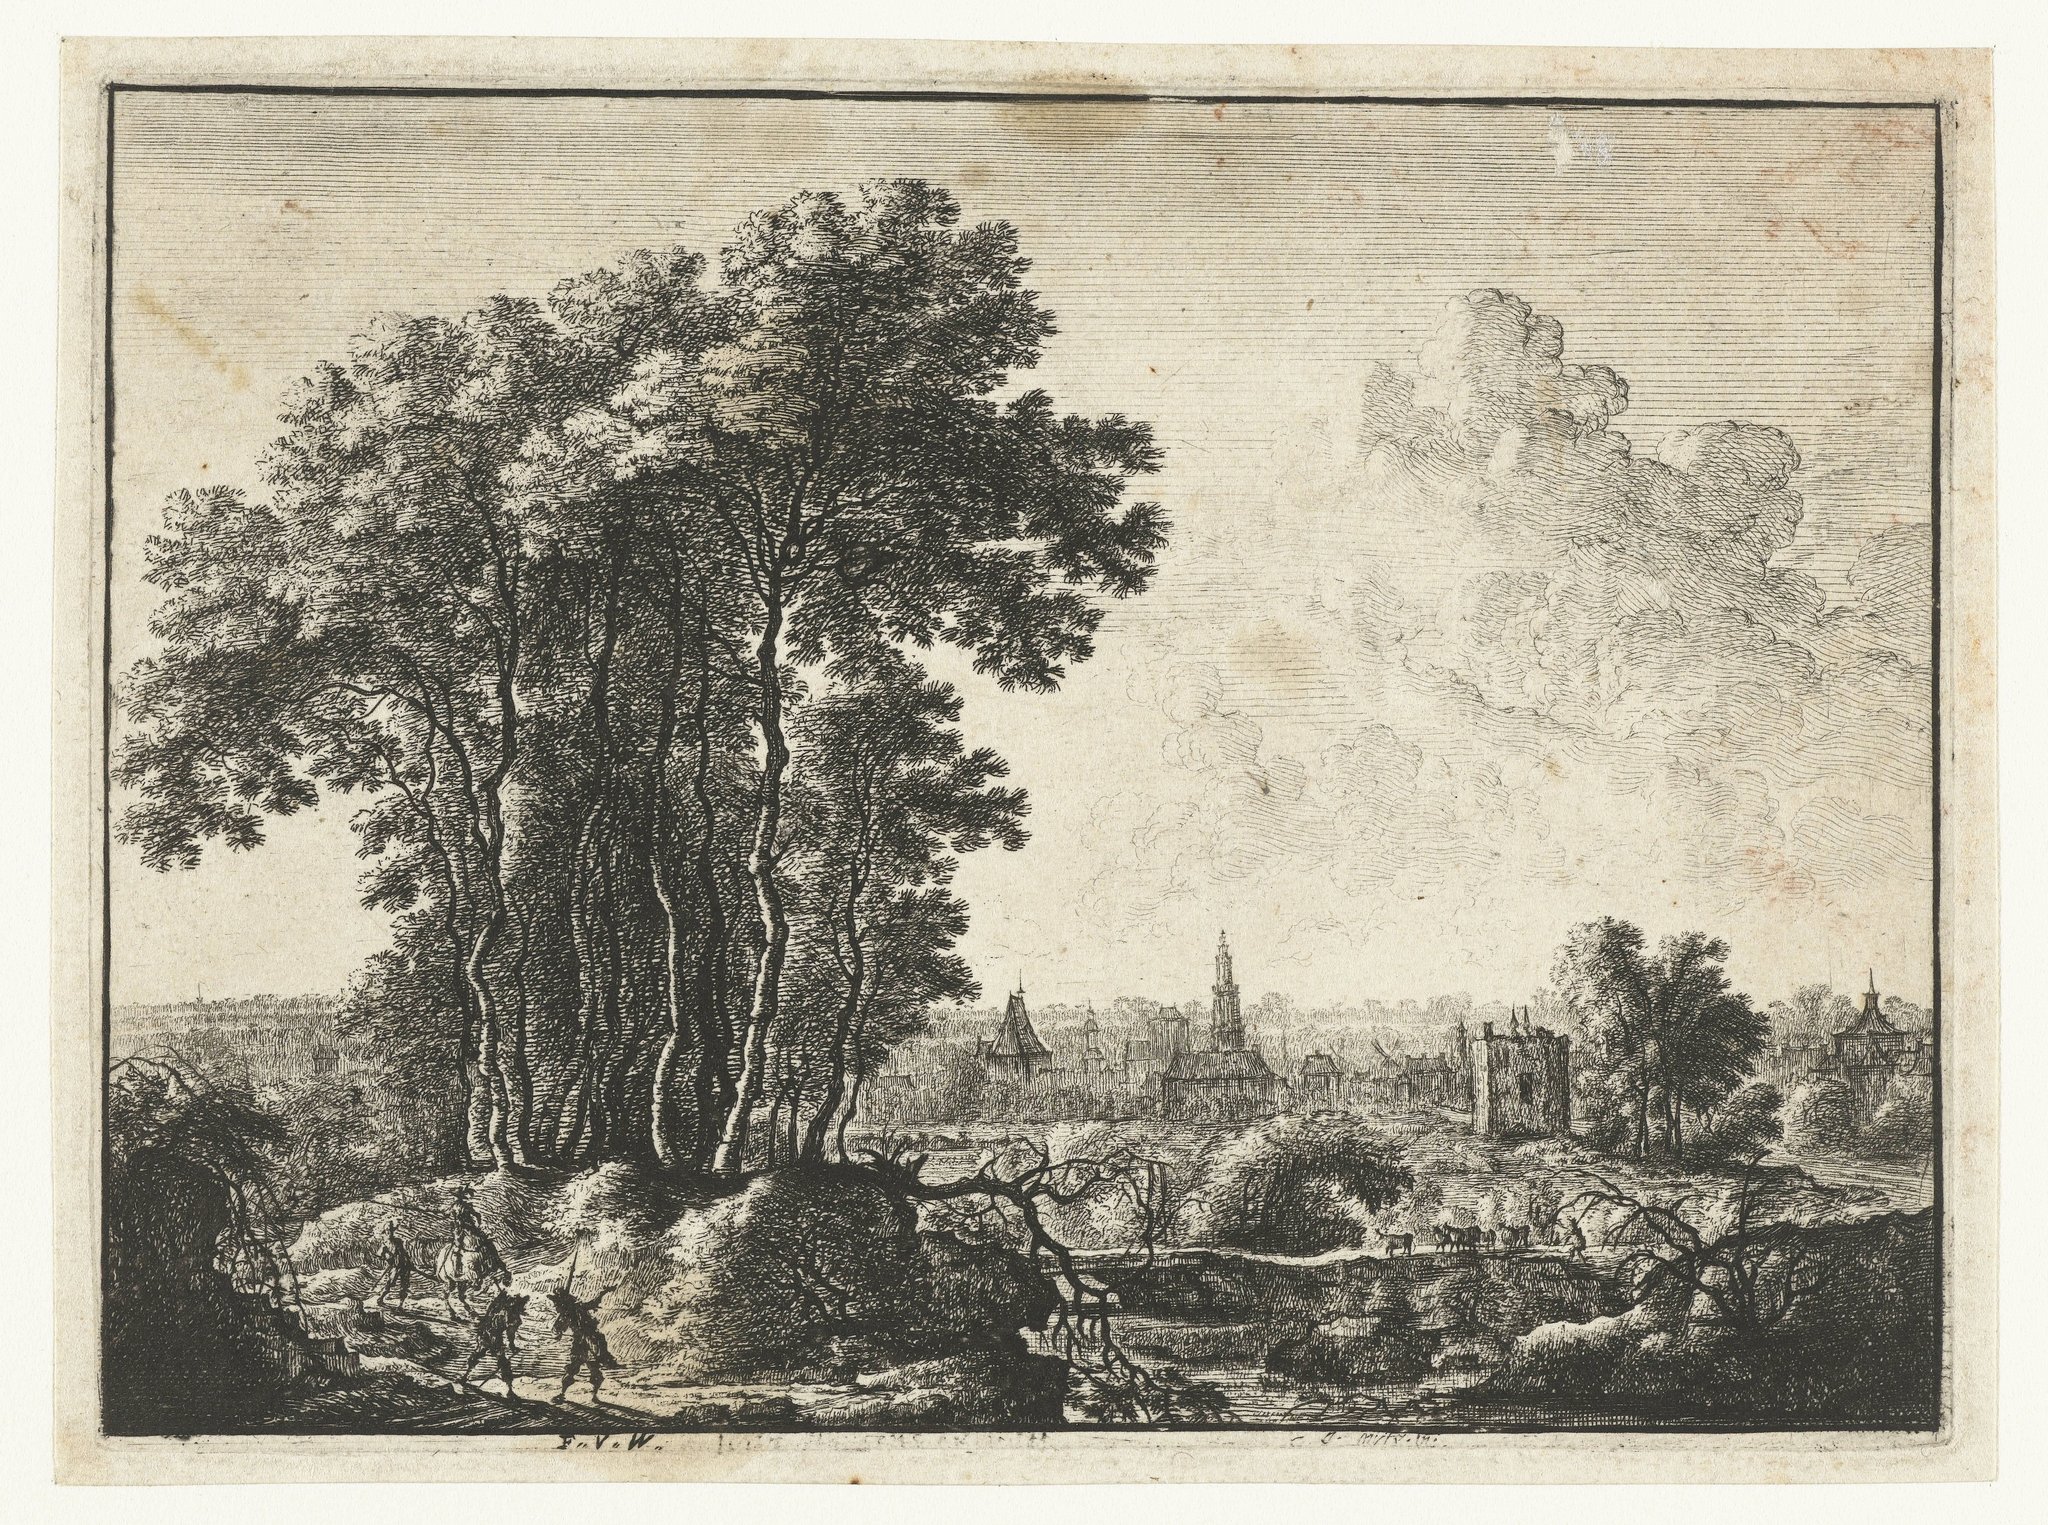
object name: print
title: Landschap met reizigers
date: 1643-1679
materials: paper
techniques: etching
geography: antwerp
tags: landscapes in the temperate zone, landscape with bridge, viaduct or aqueduct, village, windmill in landscape, 'en route', traveller under way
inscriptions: collector's mark: Lugt 240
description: Een bosachtig landschap met een dorp aan een rivier. Op de voorgrond links drie reizigers te voet en één te paard.